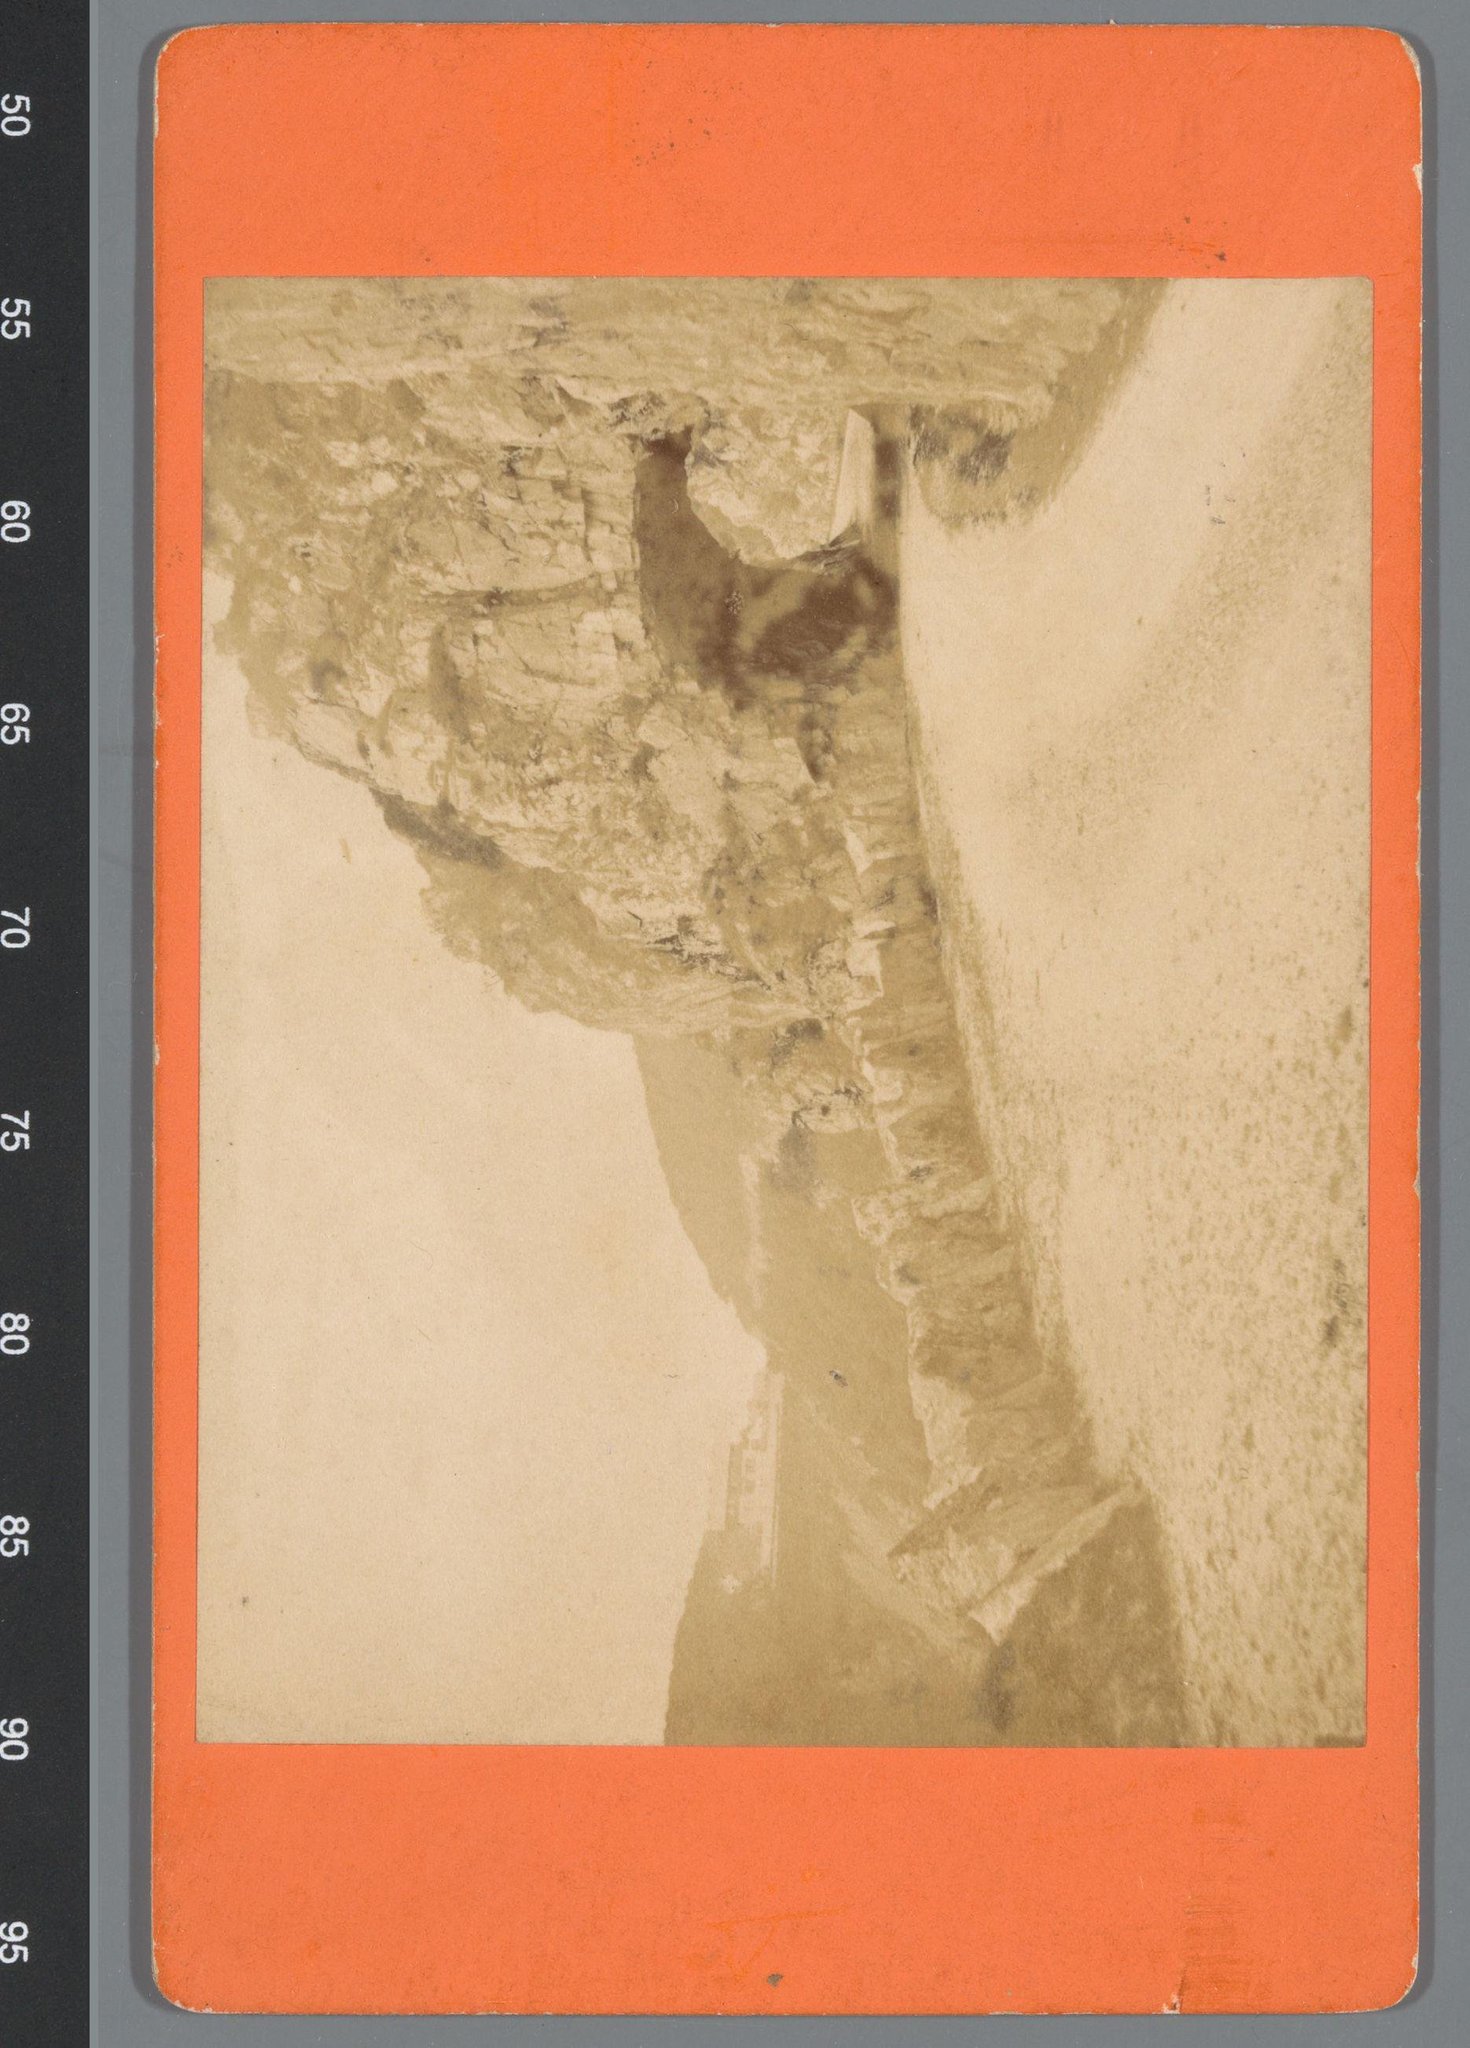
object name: photograph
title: Sites des Vosges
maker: Anonymous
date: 1881-1900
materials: cardboard, paper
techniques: albumen print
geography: vosges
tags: rock-formations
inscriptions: number: ‘27’, inscription: ‘Ad. Braun & Cie./ photographes/ a/ Dornach (Alsace)/ &/ Paris/ 3, Boulevard des Capucines, 3/ 43, Avenue de l'Opéra, 43.’